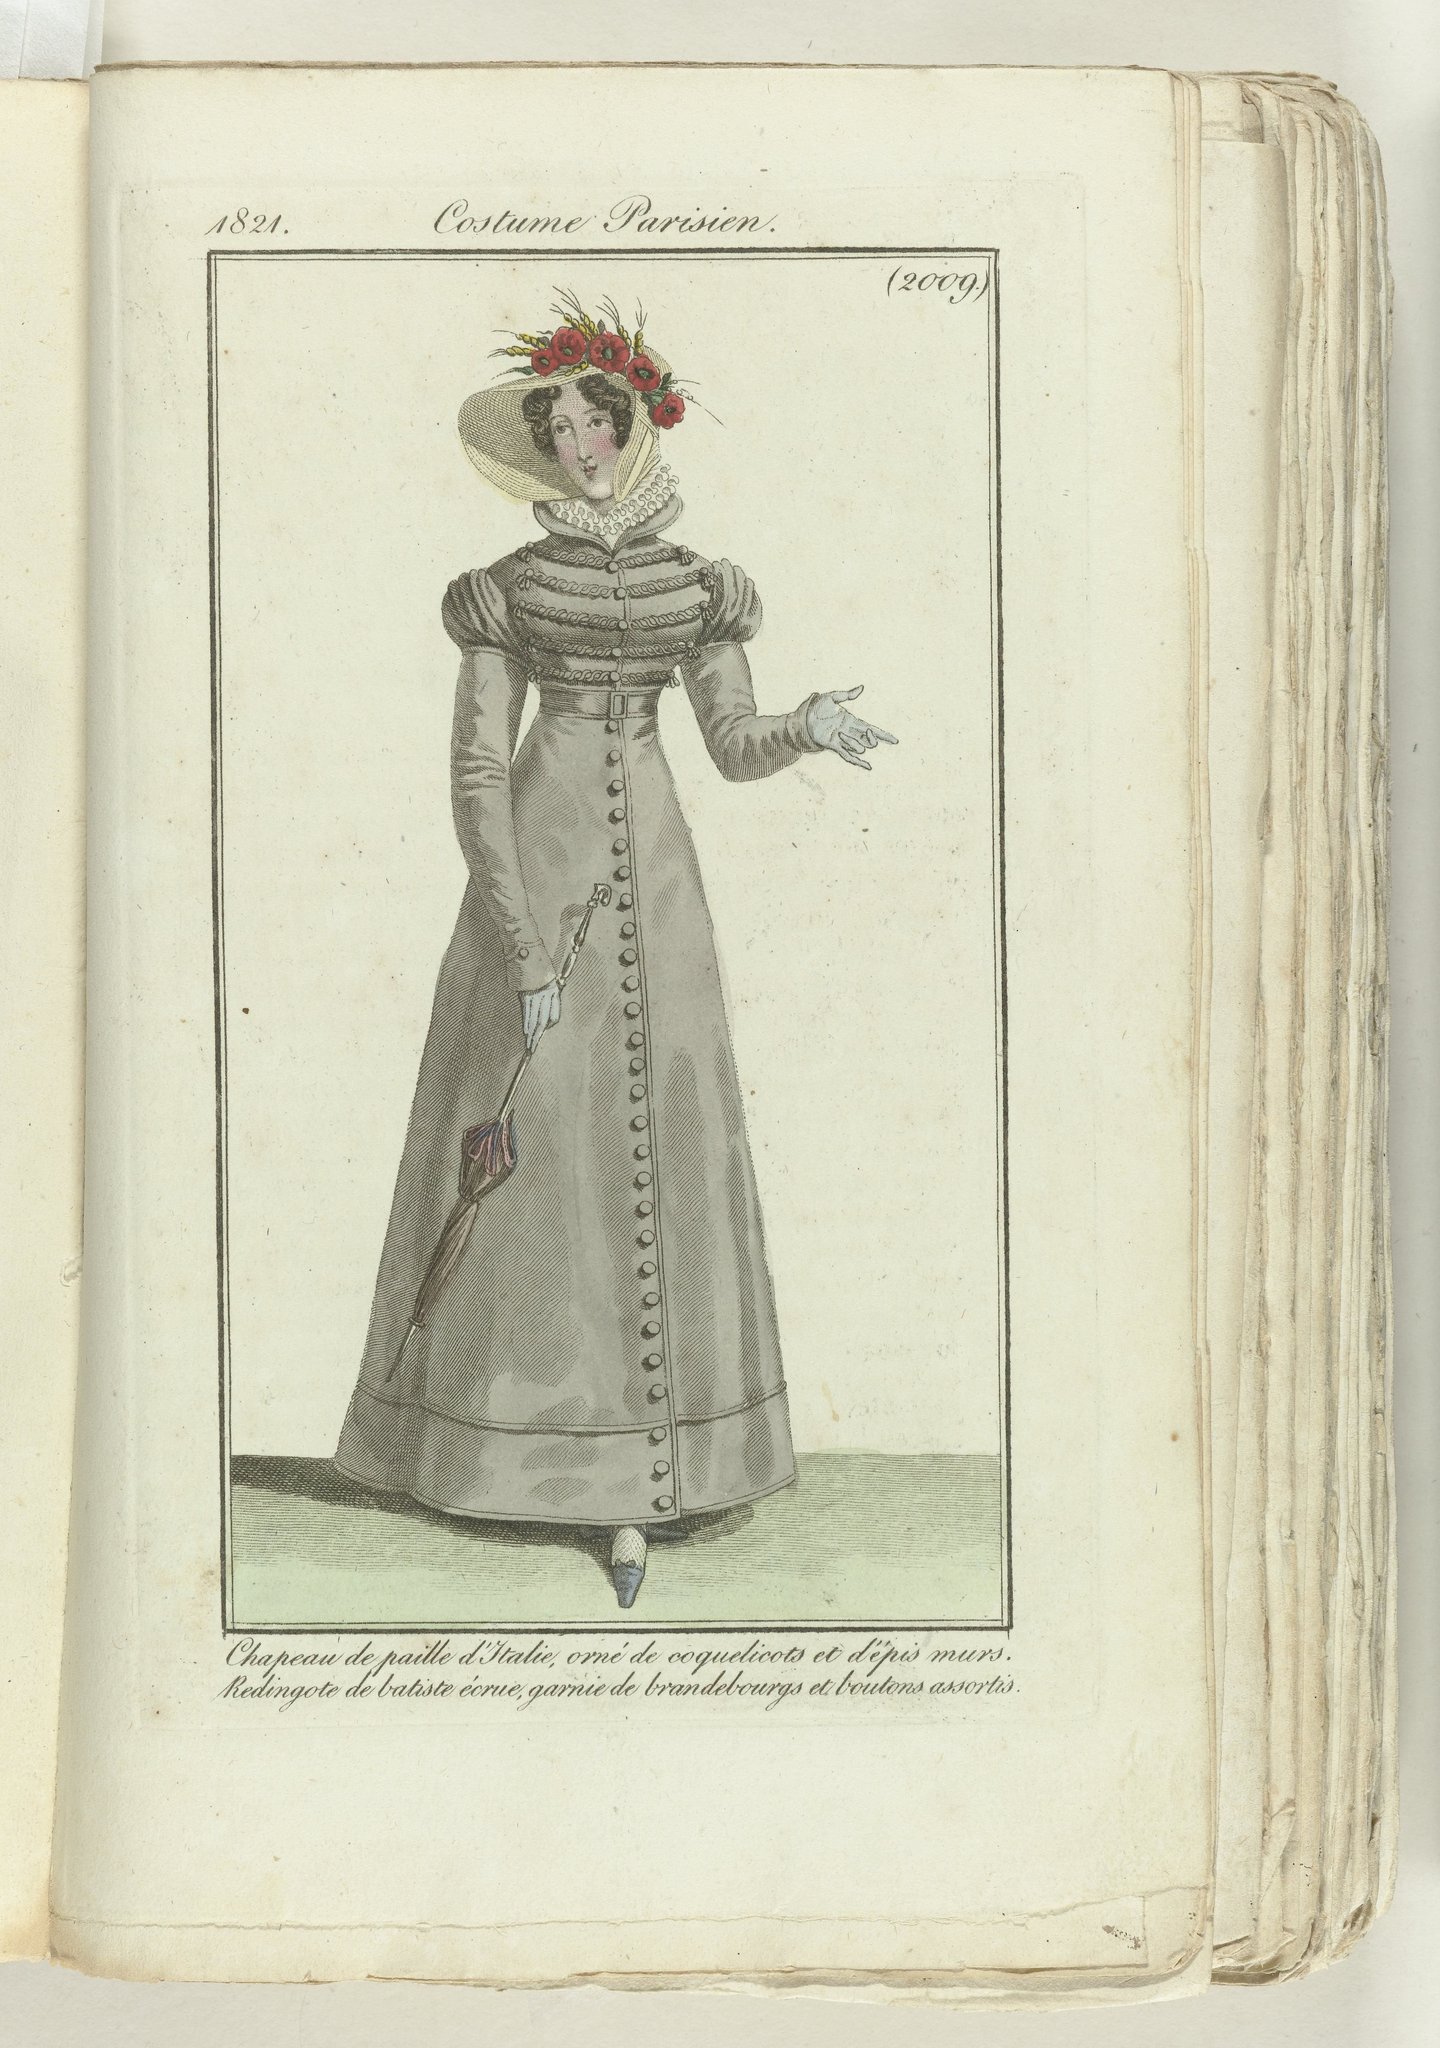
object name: fashion print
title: Journal des Dames et des Modes 1821, Costume Parisien (2009)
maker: Anonymous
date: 1821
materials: paper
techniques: etching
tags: head-gear, fashion plates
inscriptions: date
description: Prent uit het tijdschrift Journal des Dames et des Modes, 1821.